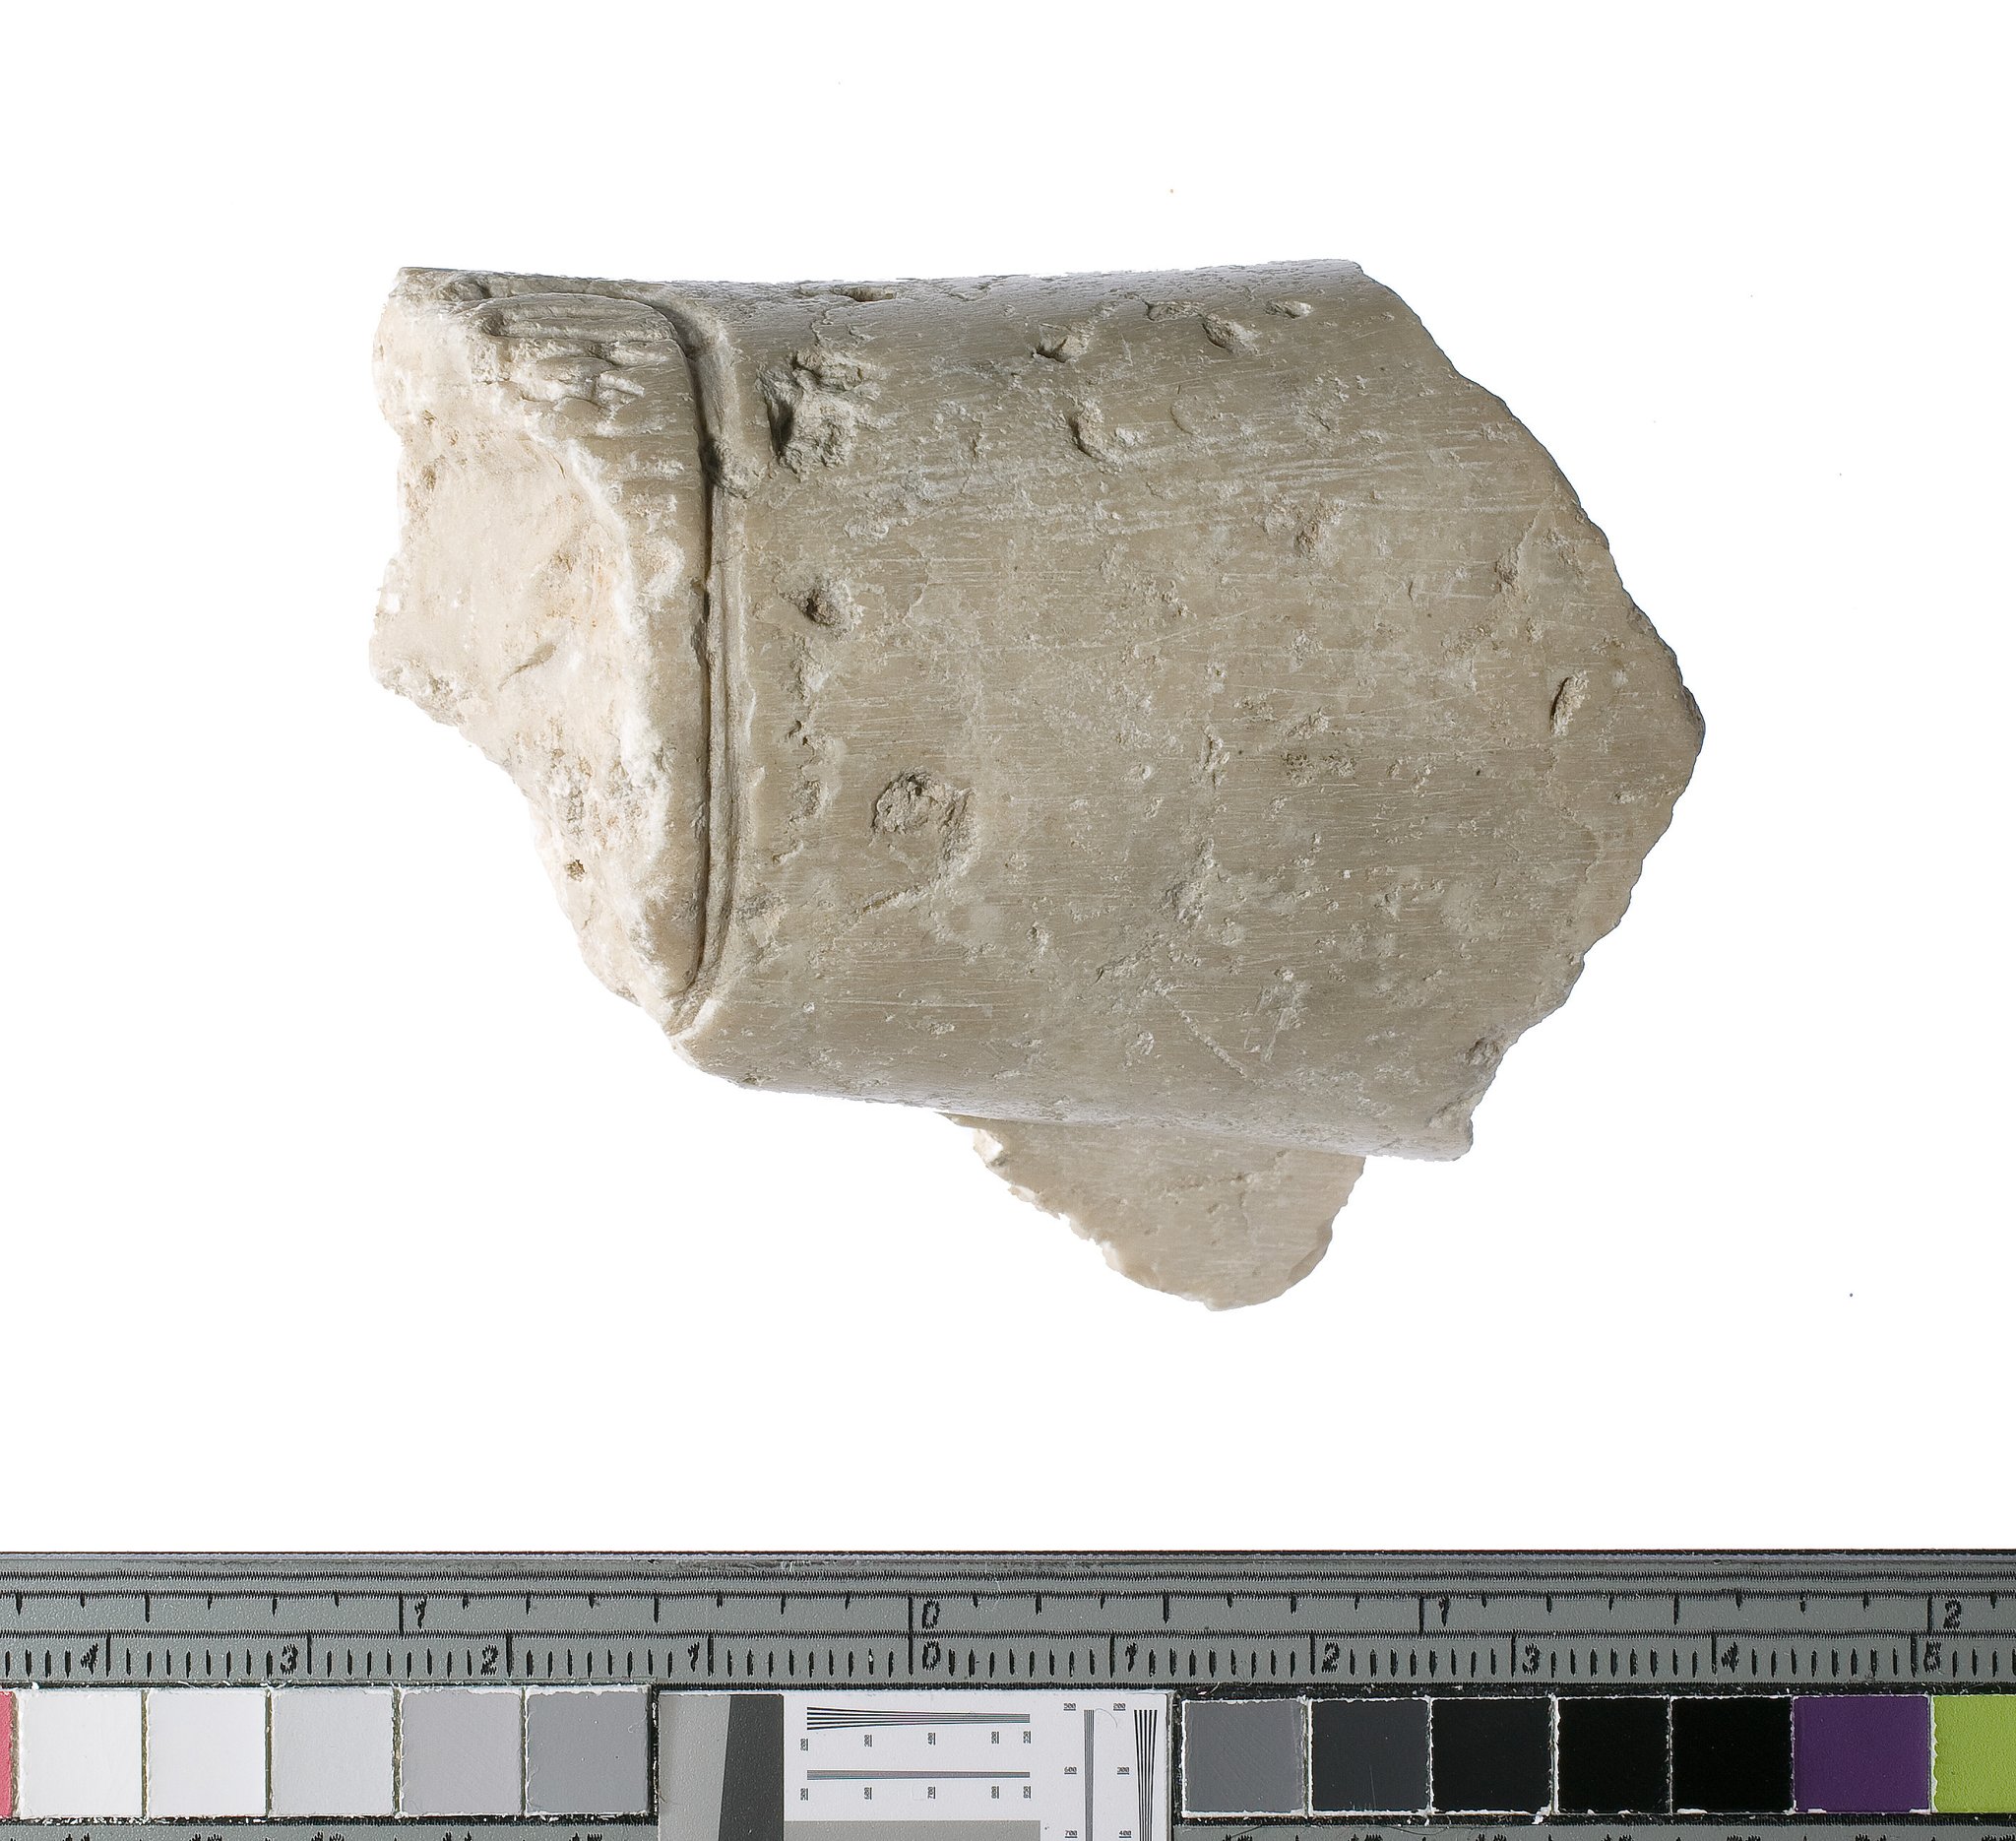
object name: forearm, aten cartouche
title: Left forearm with Aten cartouche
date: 1353-1336 BCE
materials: limestone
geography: egypt